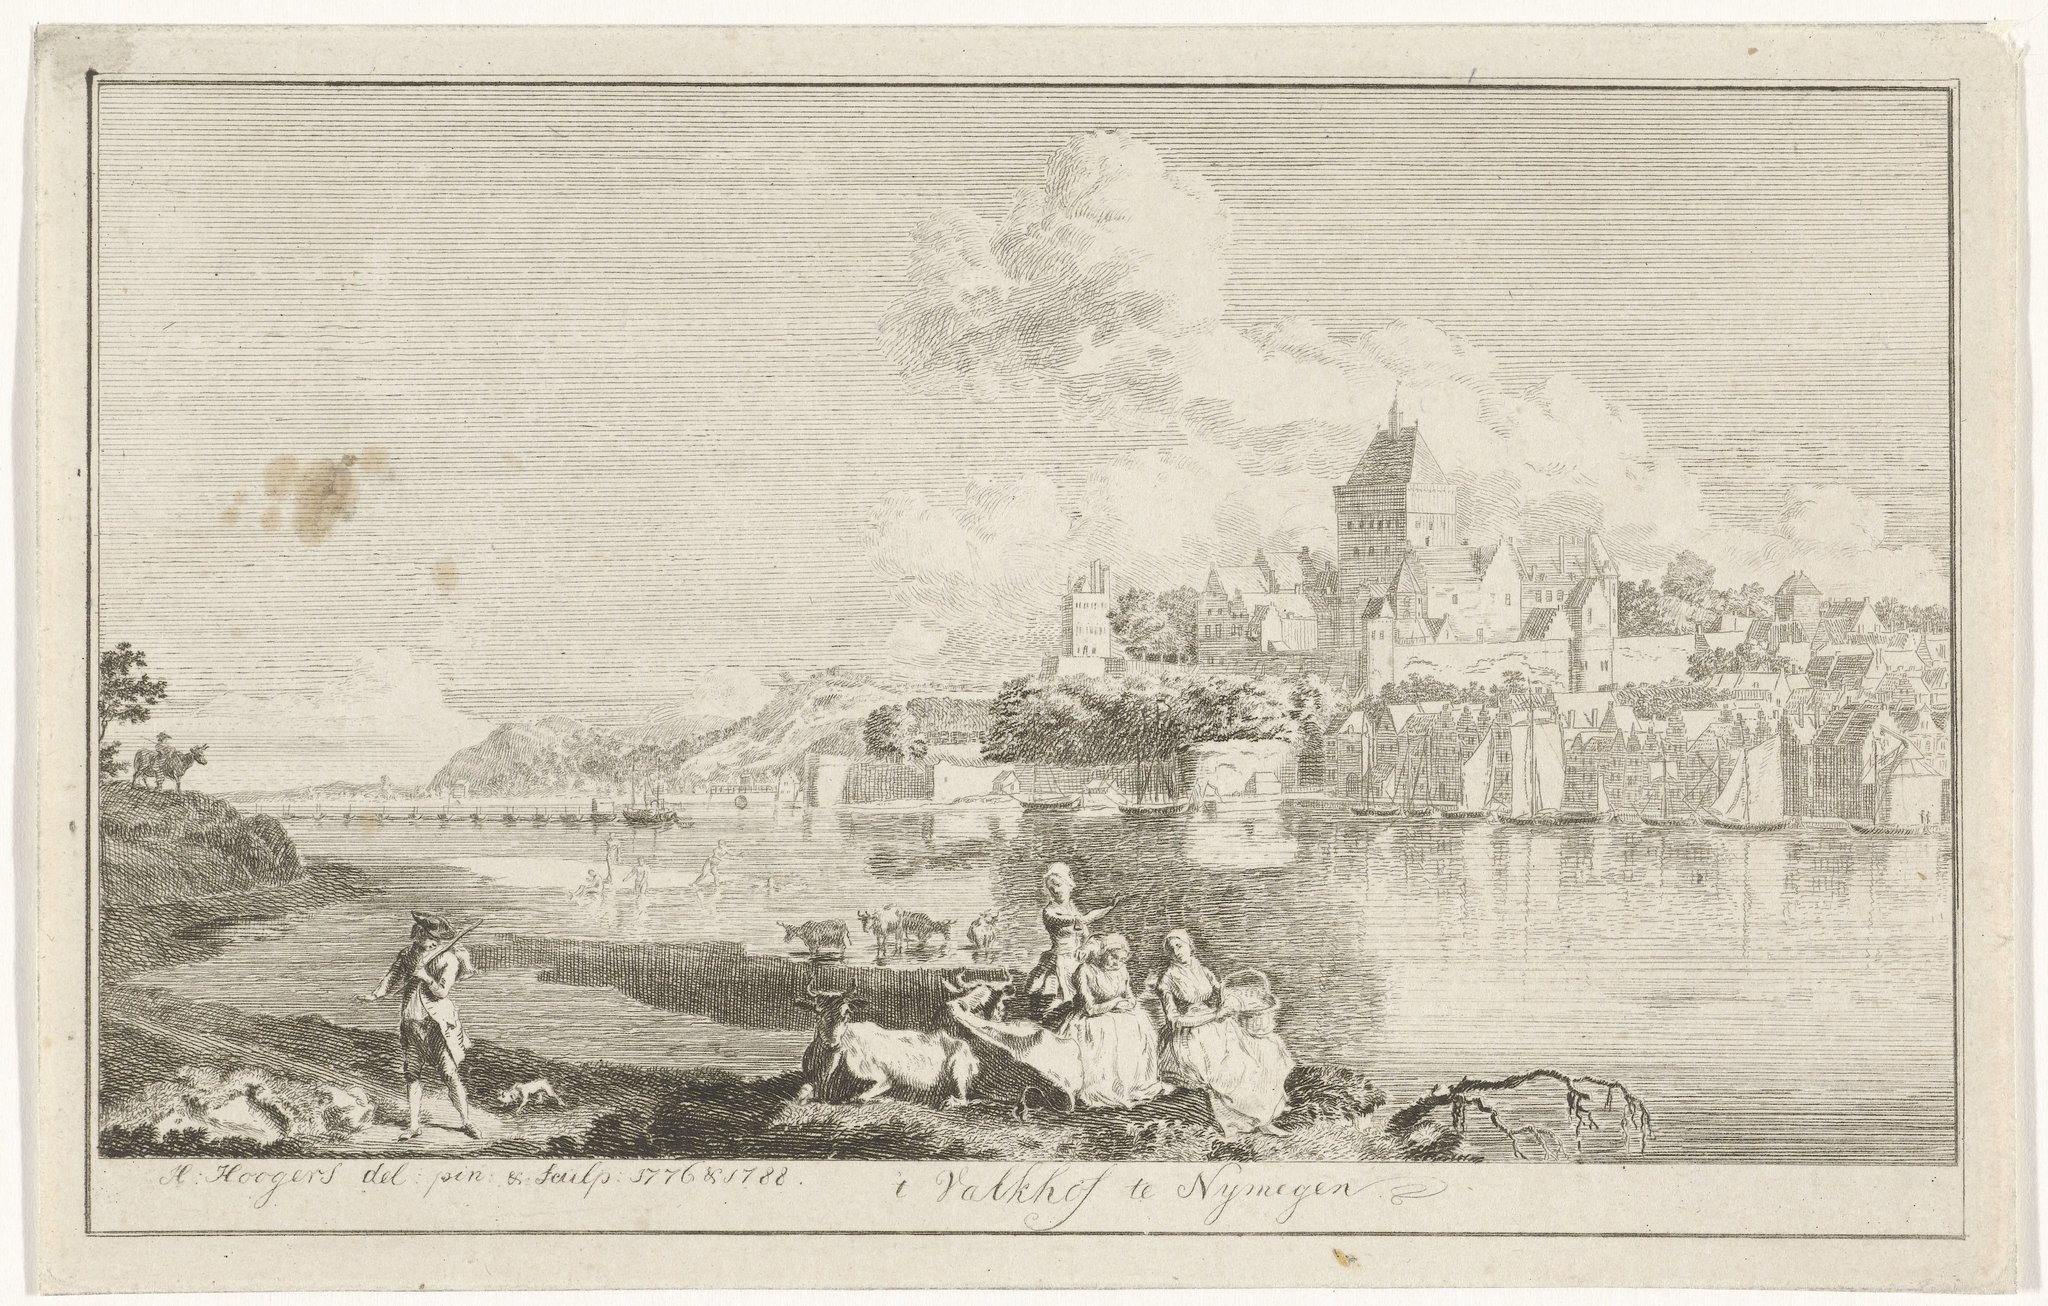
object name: print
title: Gezicht op het Valkhof te Nijmegen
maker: hendrik hoogers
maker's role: draughtsman, mayor, print maker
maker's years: 1747-1814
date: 1788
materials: paper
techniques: etching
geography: nijmegen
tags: landscapes with waters, waterscapes, seascapes (in the temperate zone) (+ landscape with figures, staffage)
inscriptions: collector's mark: Lugt 2228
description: Gezicht op het Valkhof te Nijmegen. Op de voorgrond drie vrouwen bij twee liggende koeien. Links een man met een hond.